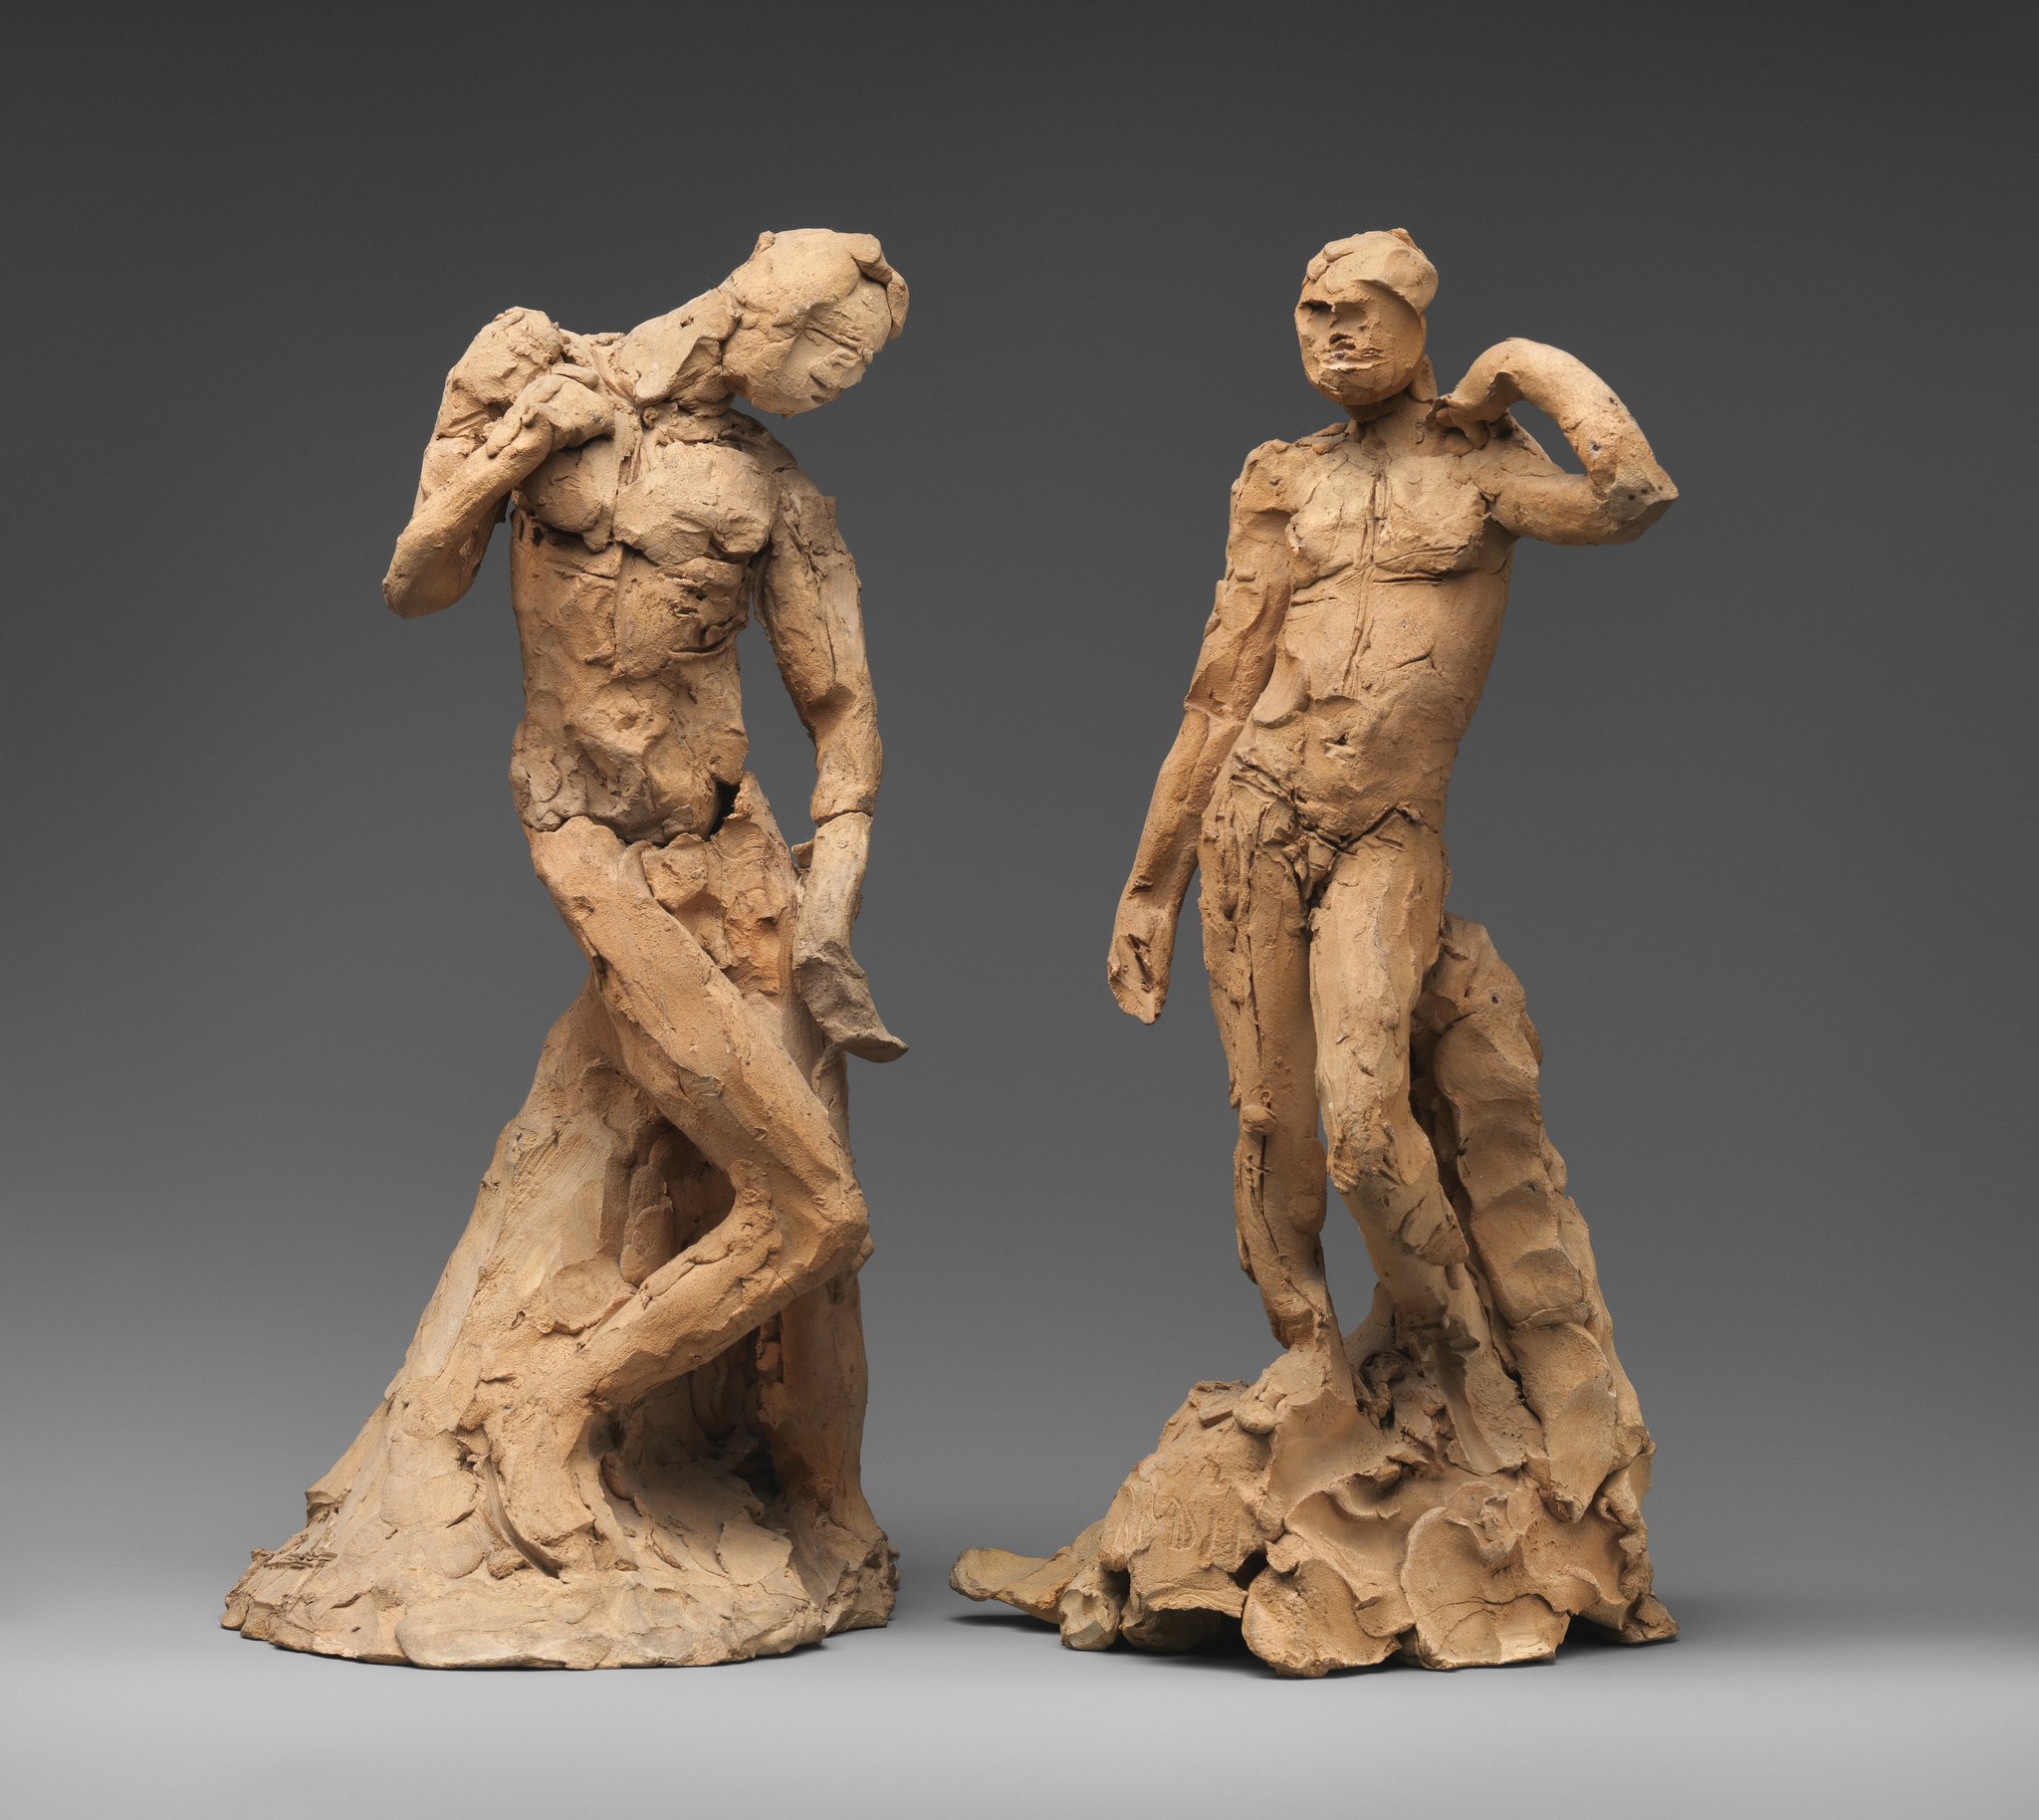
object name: statuette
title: Pair of Standing Nude Male Figures Demonstrating the Principles of Contrapposto according to Michelangelo and Phidias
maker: auguste rodin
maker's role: artist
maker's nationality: french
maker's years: 1840-1917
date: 1911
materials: terracotta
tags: male nudes